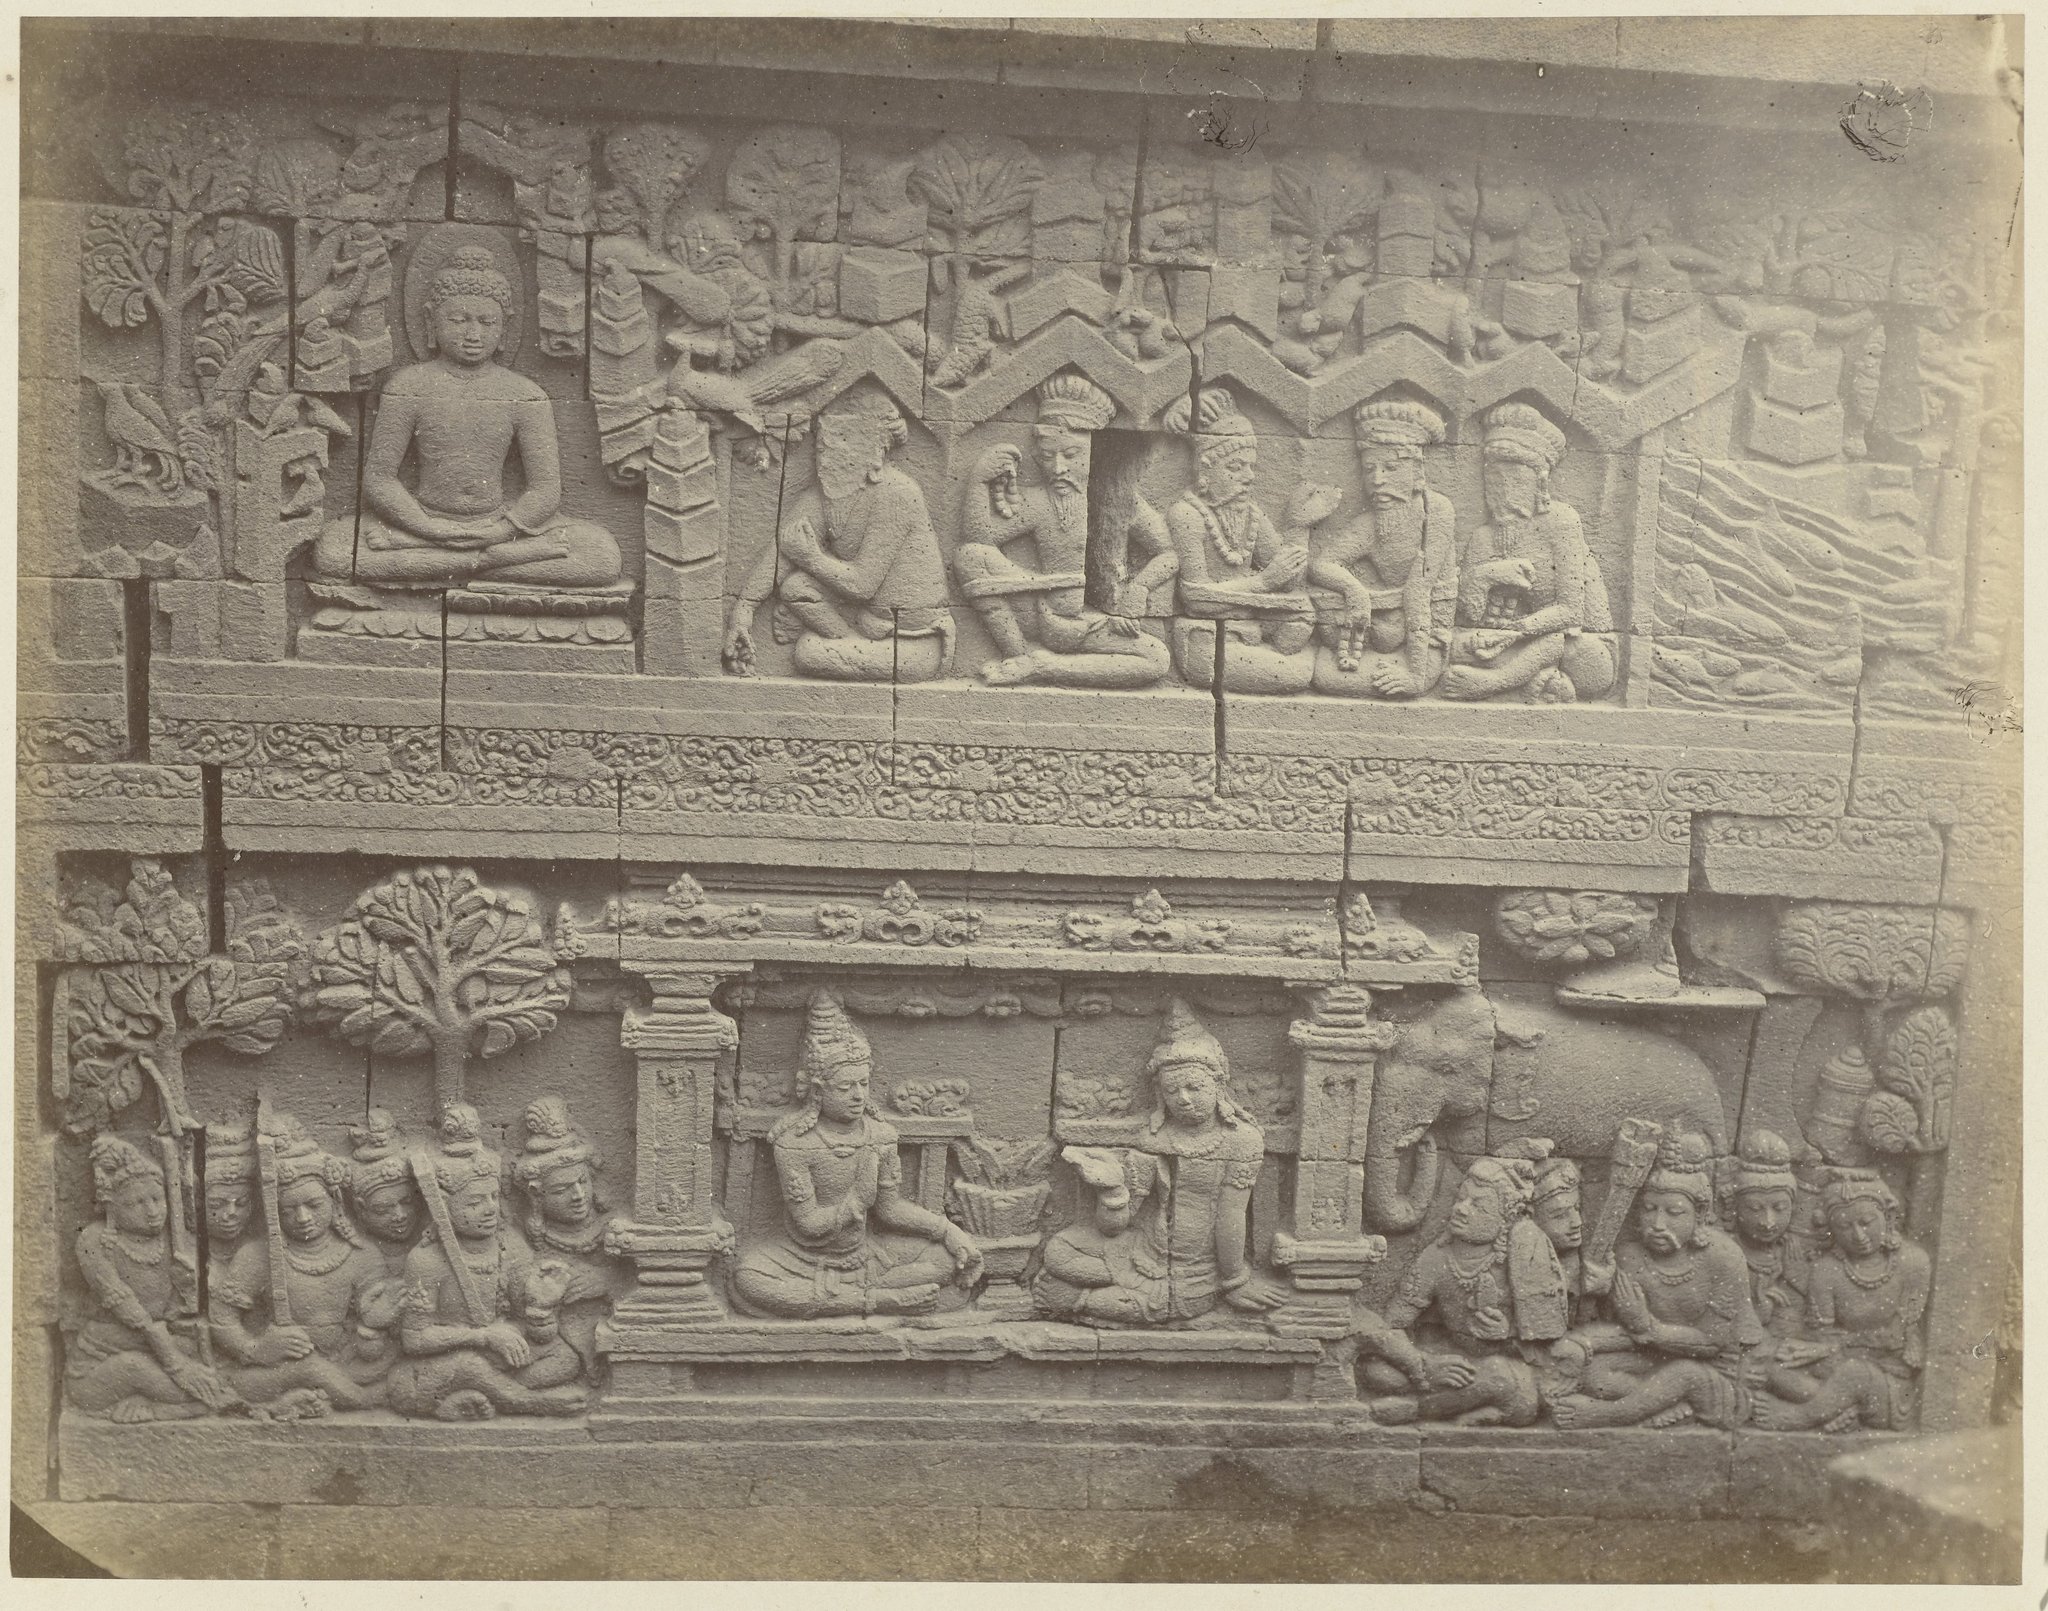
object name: photograph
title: Idem 2e gaanderij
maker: isidore kinsbergen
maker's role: fotograaf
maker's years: 1821-1905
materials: cardboard, paper, photographic support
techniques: albumen print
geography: java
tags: borobudur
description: Gallery I, main wall, north side 37 (top): Relief 1a-76, Lalitavistara relief, Siddhartha meditating in Gaya, accompanied by ascetics. 37 (bottom): relief 1b-76, Avadana relief, Rudrayana story, King Rudrayana announces his renouncement of the throne in favour of his son Cikhandin. Borobudur village, Magelang district, Central Java province, 778-824 AD.